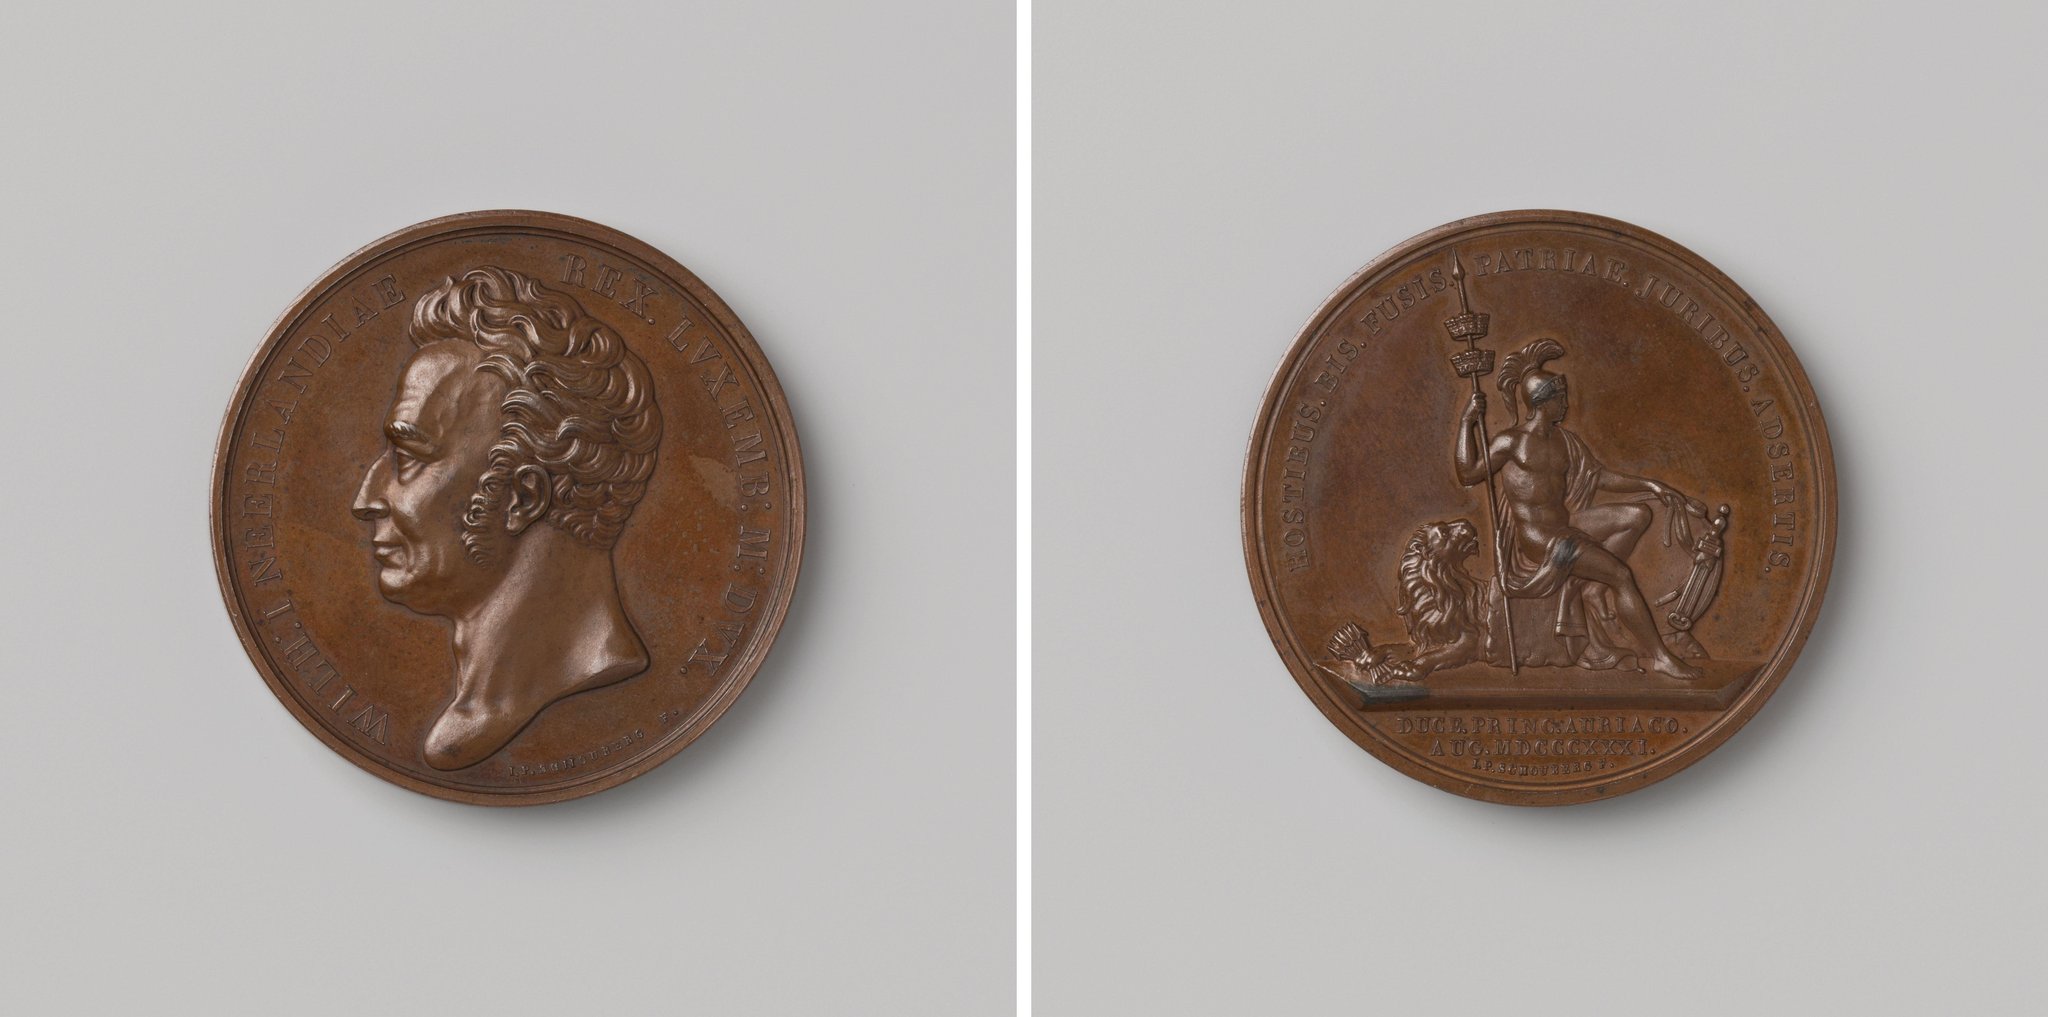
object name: history medal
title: Overwinningen bij Hasselt en Leuven, ter ere van Willem I Frederik, koning der Nederlanden, penning verleend aan Mr. J.H. Holle, luitenant-kolonel bij de mobiele Zuid-Hollandsche schutterij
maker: johannis petrus schouberg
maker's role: die cutter, draughtsman, print maker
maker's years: 1798-1864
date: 1831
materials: bronze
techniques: striking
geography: netherlands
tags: berlin, william i of the netherlands, the hague, william ii of the netherlands, louvain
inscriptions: edge inscription: ‘Hortibus Bis Fusis Patriae Juribus Adsertis Duce Princ. Auriaco Aug MDCCCXXXI’, edge inscription: ‘Wilh.1 Neerlandiae Rex. Luxemb. M.D.V.X’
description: Bronzen medaille. Voorzijde: borstbeeld van Willem I en randschrift. Keerzijde: Mars (?) en randschrift. Deze penning is vervaardigd van in de Tiendaagse Veldtocht op de vijand veroverd geschut.